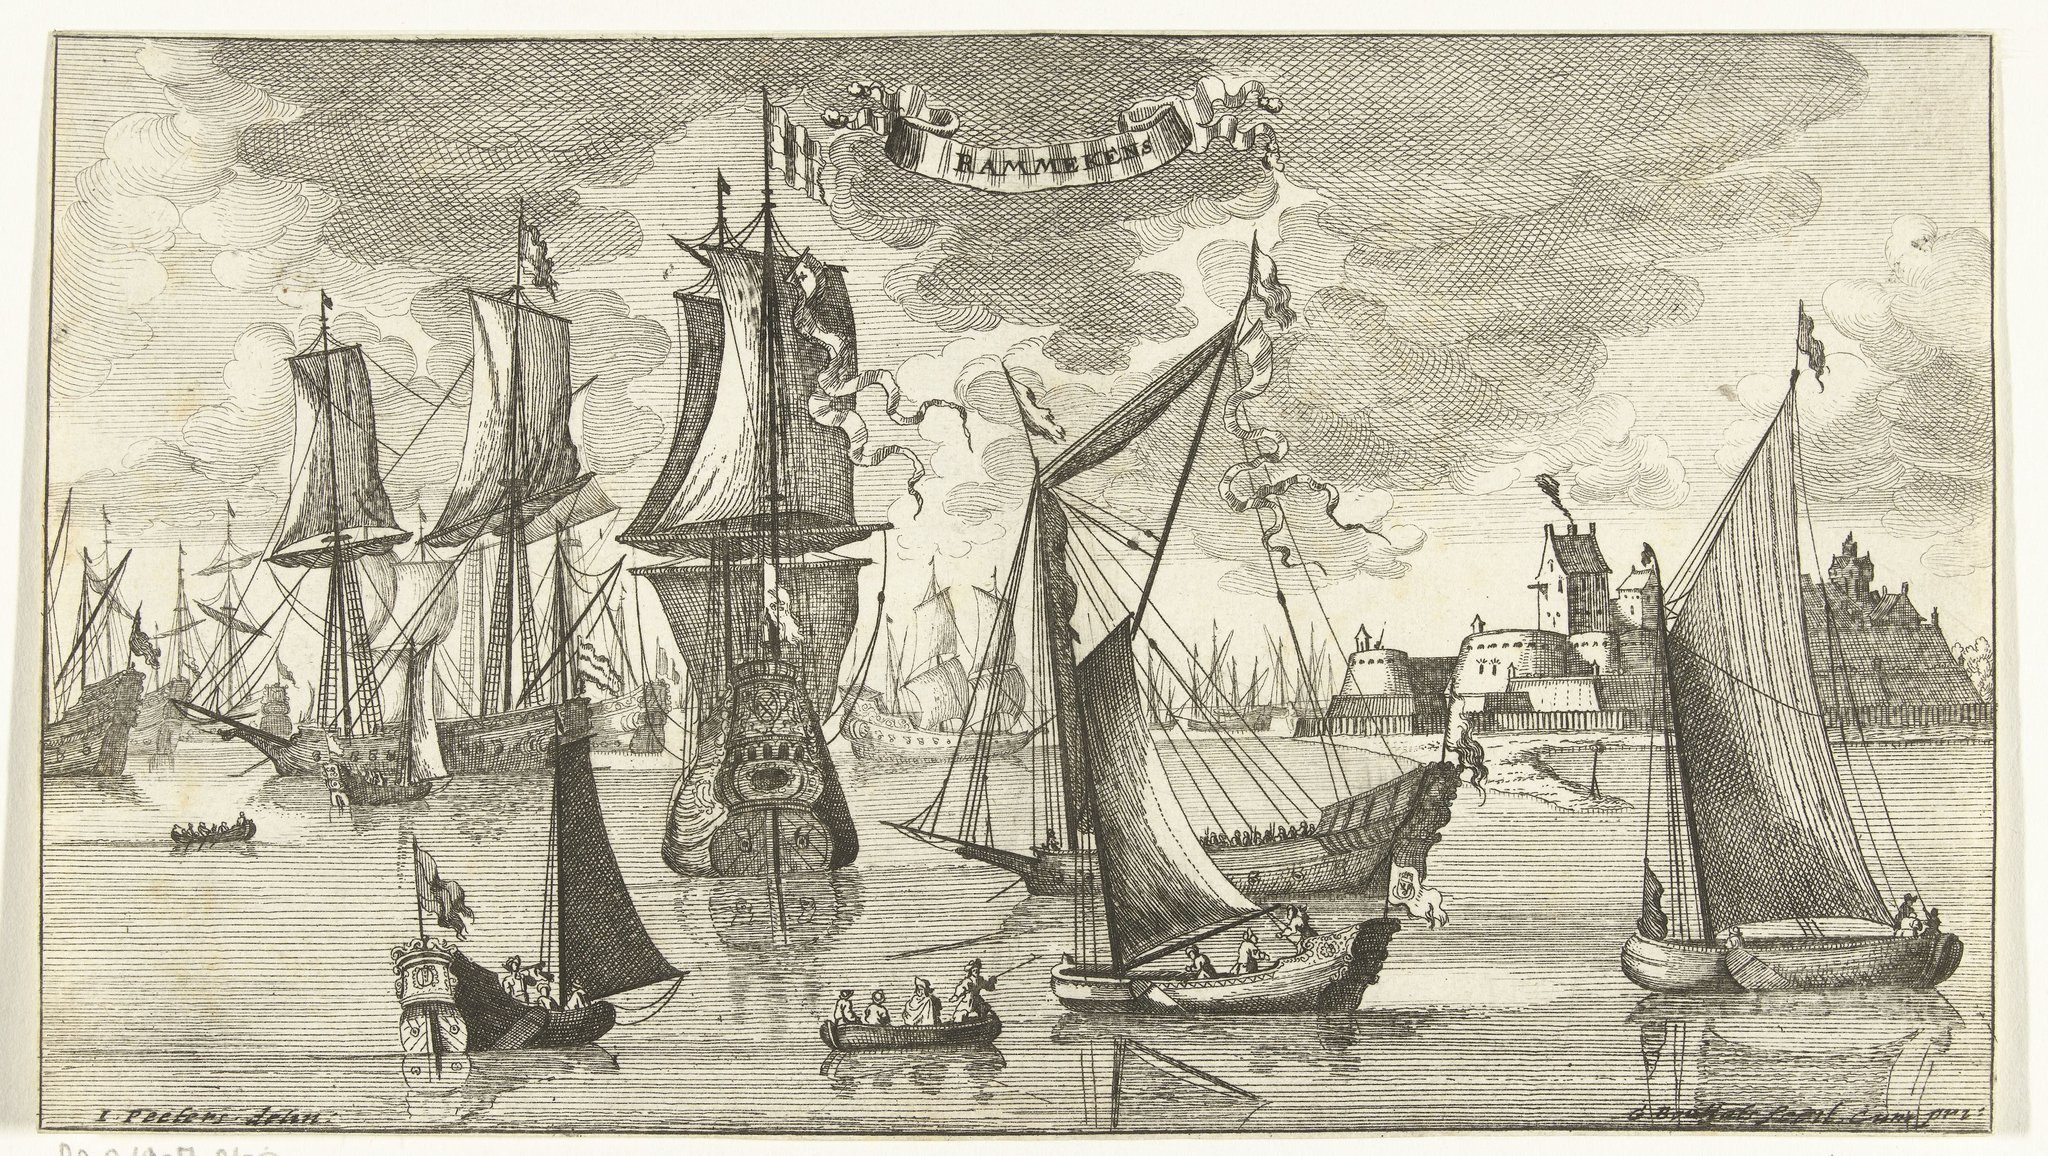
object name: print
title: Thooneel der Steden ende Sterckten van 't Vereenight Nederlandt met d'aengrensende Plaetsen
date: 1679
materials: paper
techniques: etching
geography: antwerp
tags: prospect of city, town panorama, silhouette of city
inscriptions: inscription: ‘ligt als eenen punt tusschen Vlissingen en Armuijden, etc.’, collector's mark: Lugt 2228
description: Gezicht op het zeefort Rammekens. Op de voorgrond, buiten de vesting verzamelen schepen zich en worden passagiers aan boord van galjoenen gebracht. Boven het stadsgezicht een cartouche met de naam van de stad.